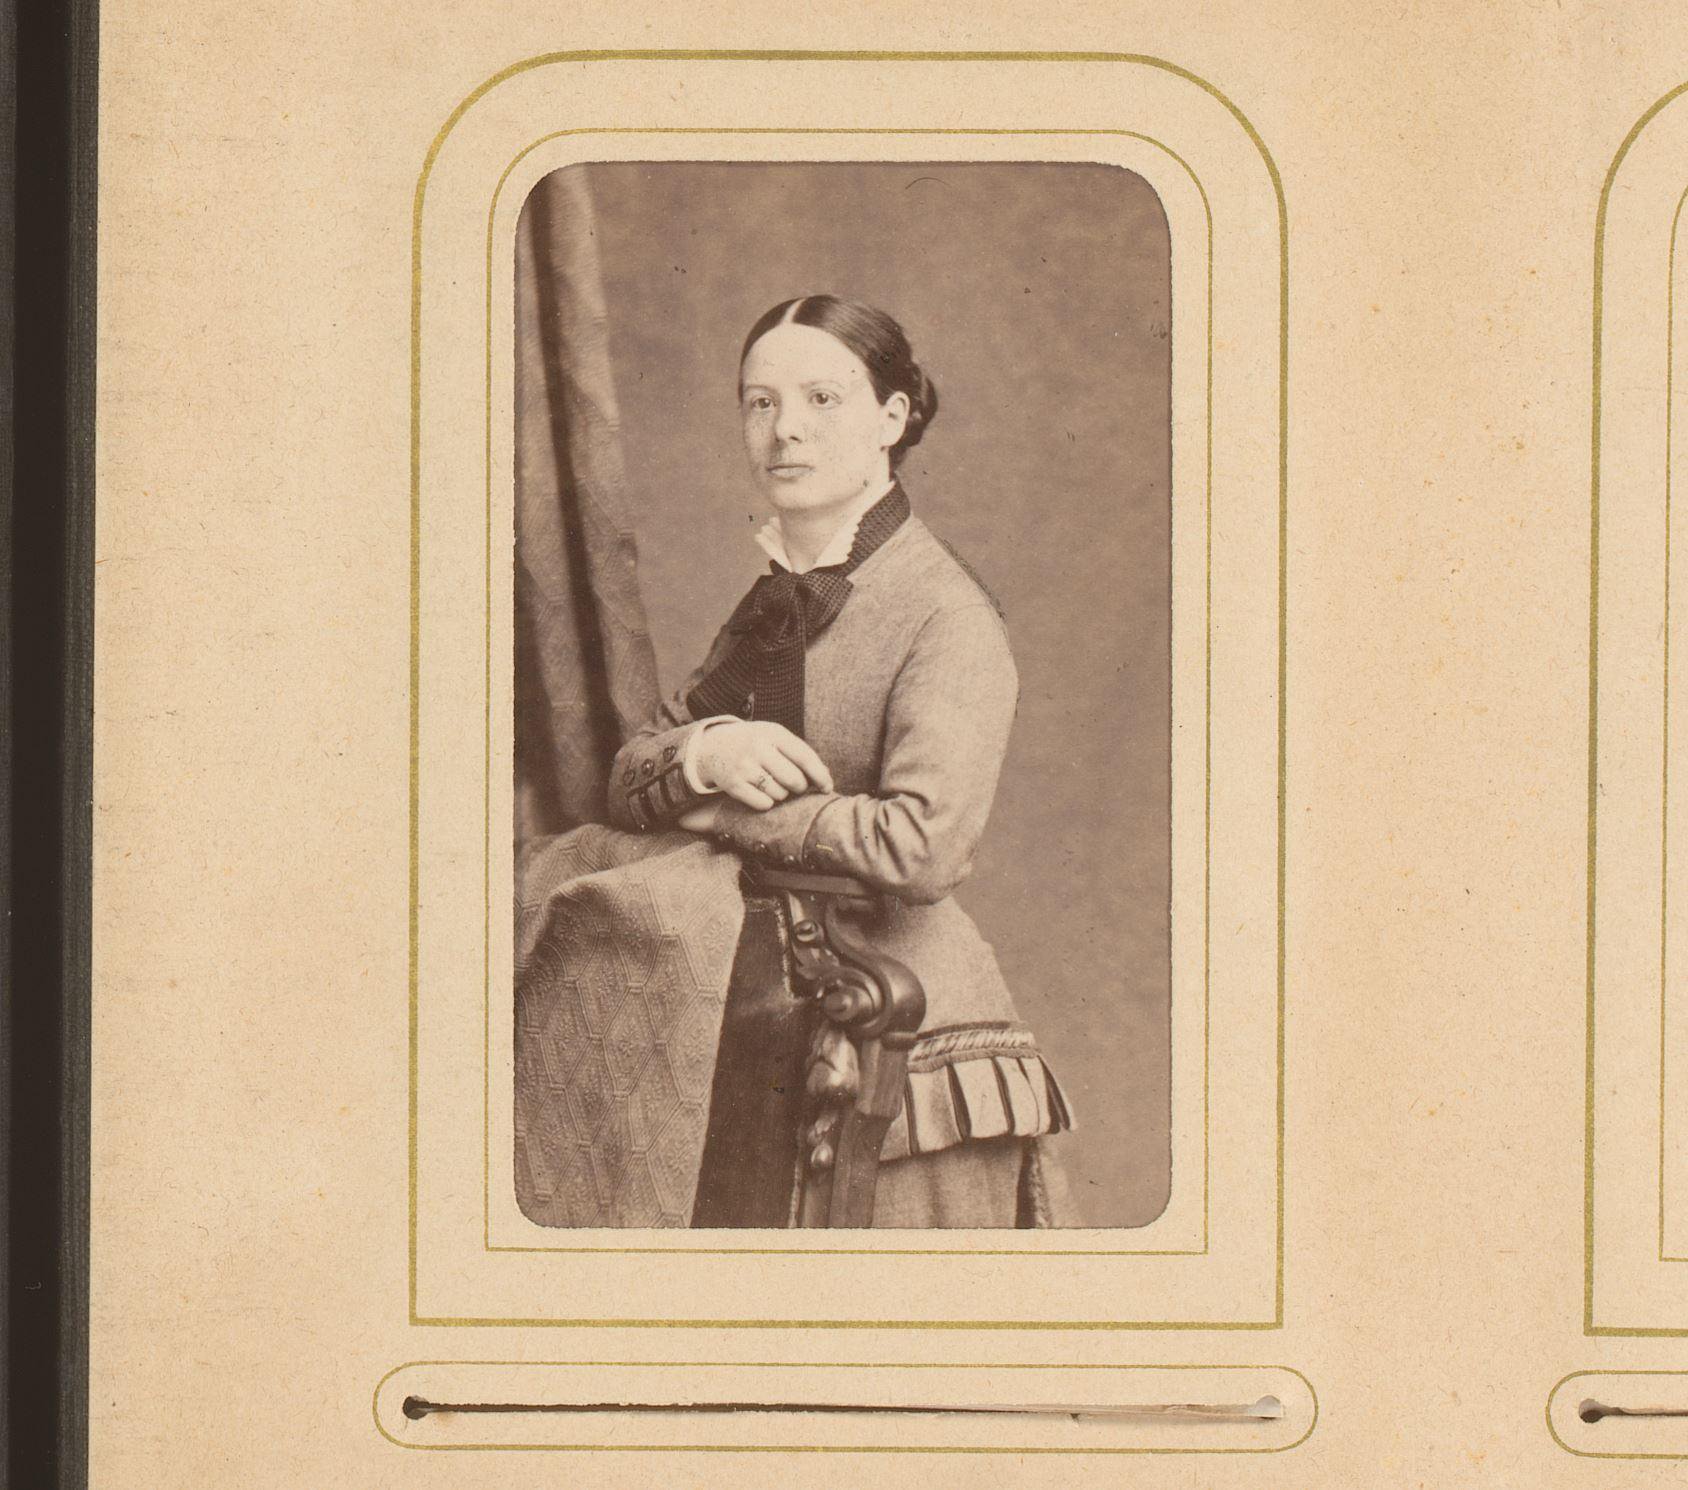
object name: album leaf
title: Portret van een staand meisje, leunend op de leuning van een stoel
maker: a. böeseken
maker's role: fotograaf, lithograaf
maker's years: 1834-1919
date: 1858-1890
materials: cardboard, photographic support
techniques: albumen print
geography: rotterdam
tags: historical persons - bb - woman, girl (child between toddler and youth), standing figure - aa - female human figure, chair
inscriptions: inscription: ‘A. Böeseken/ Photographisch Atelier/ Hoogstraat over de/ Vlasmarkt/ ROTTERDAM.’